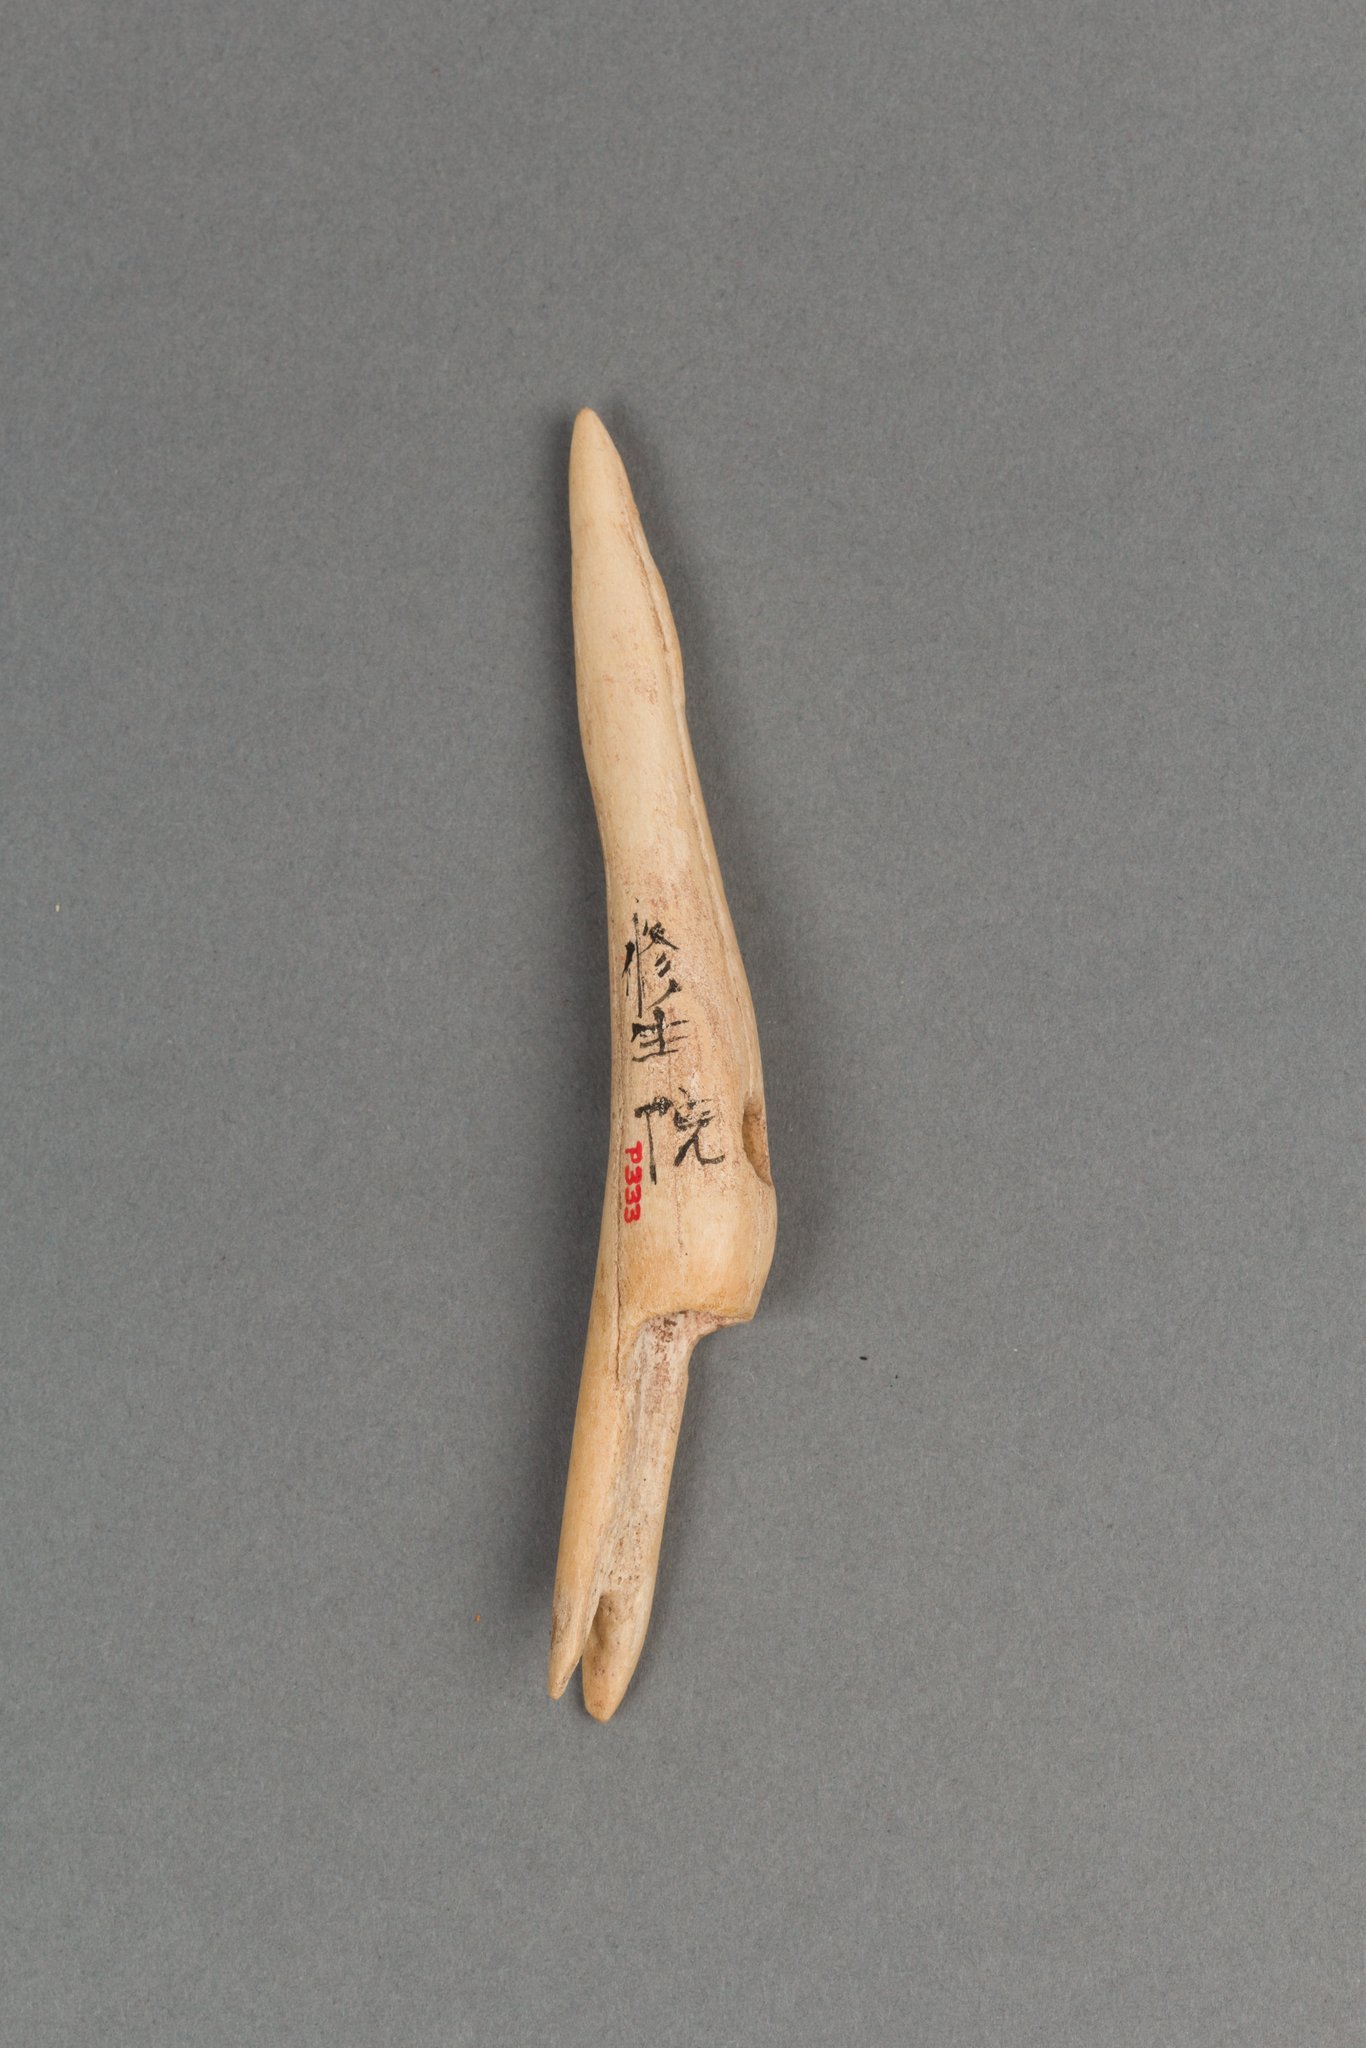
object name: toggle harpoon head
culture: japanese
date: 1200-200 BCE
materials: bone